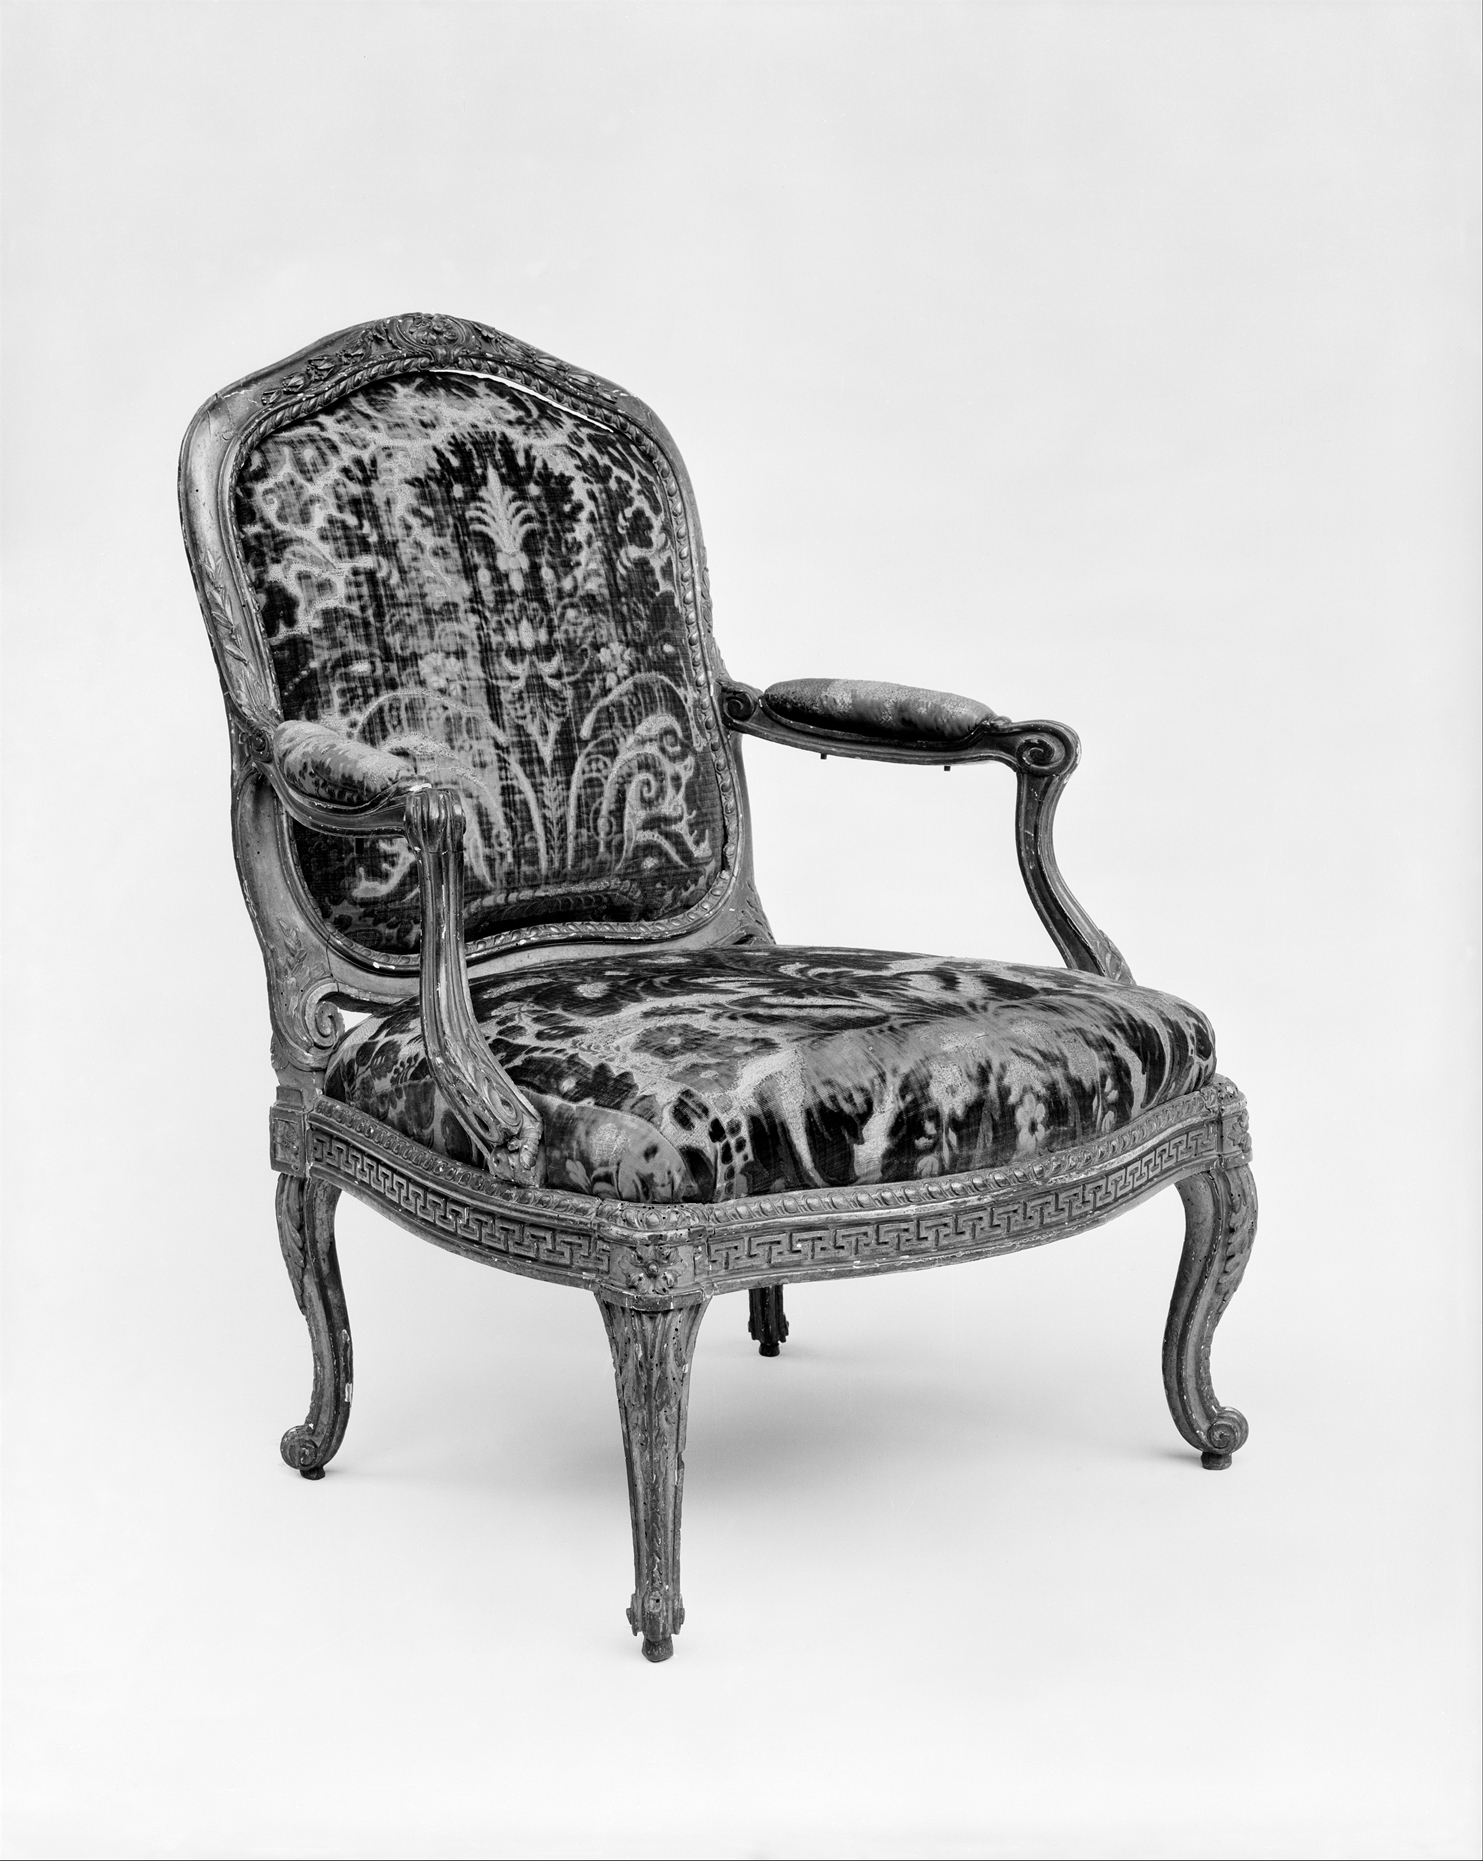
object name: armchair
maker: jean-jacques pothier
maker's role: maker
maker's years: 1750-1780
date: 1765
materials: wood, velvet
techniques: carving, cutting, gilding